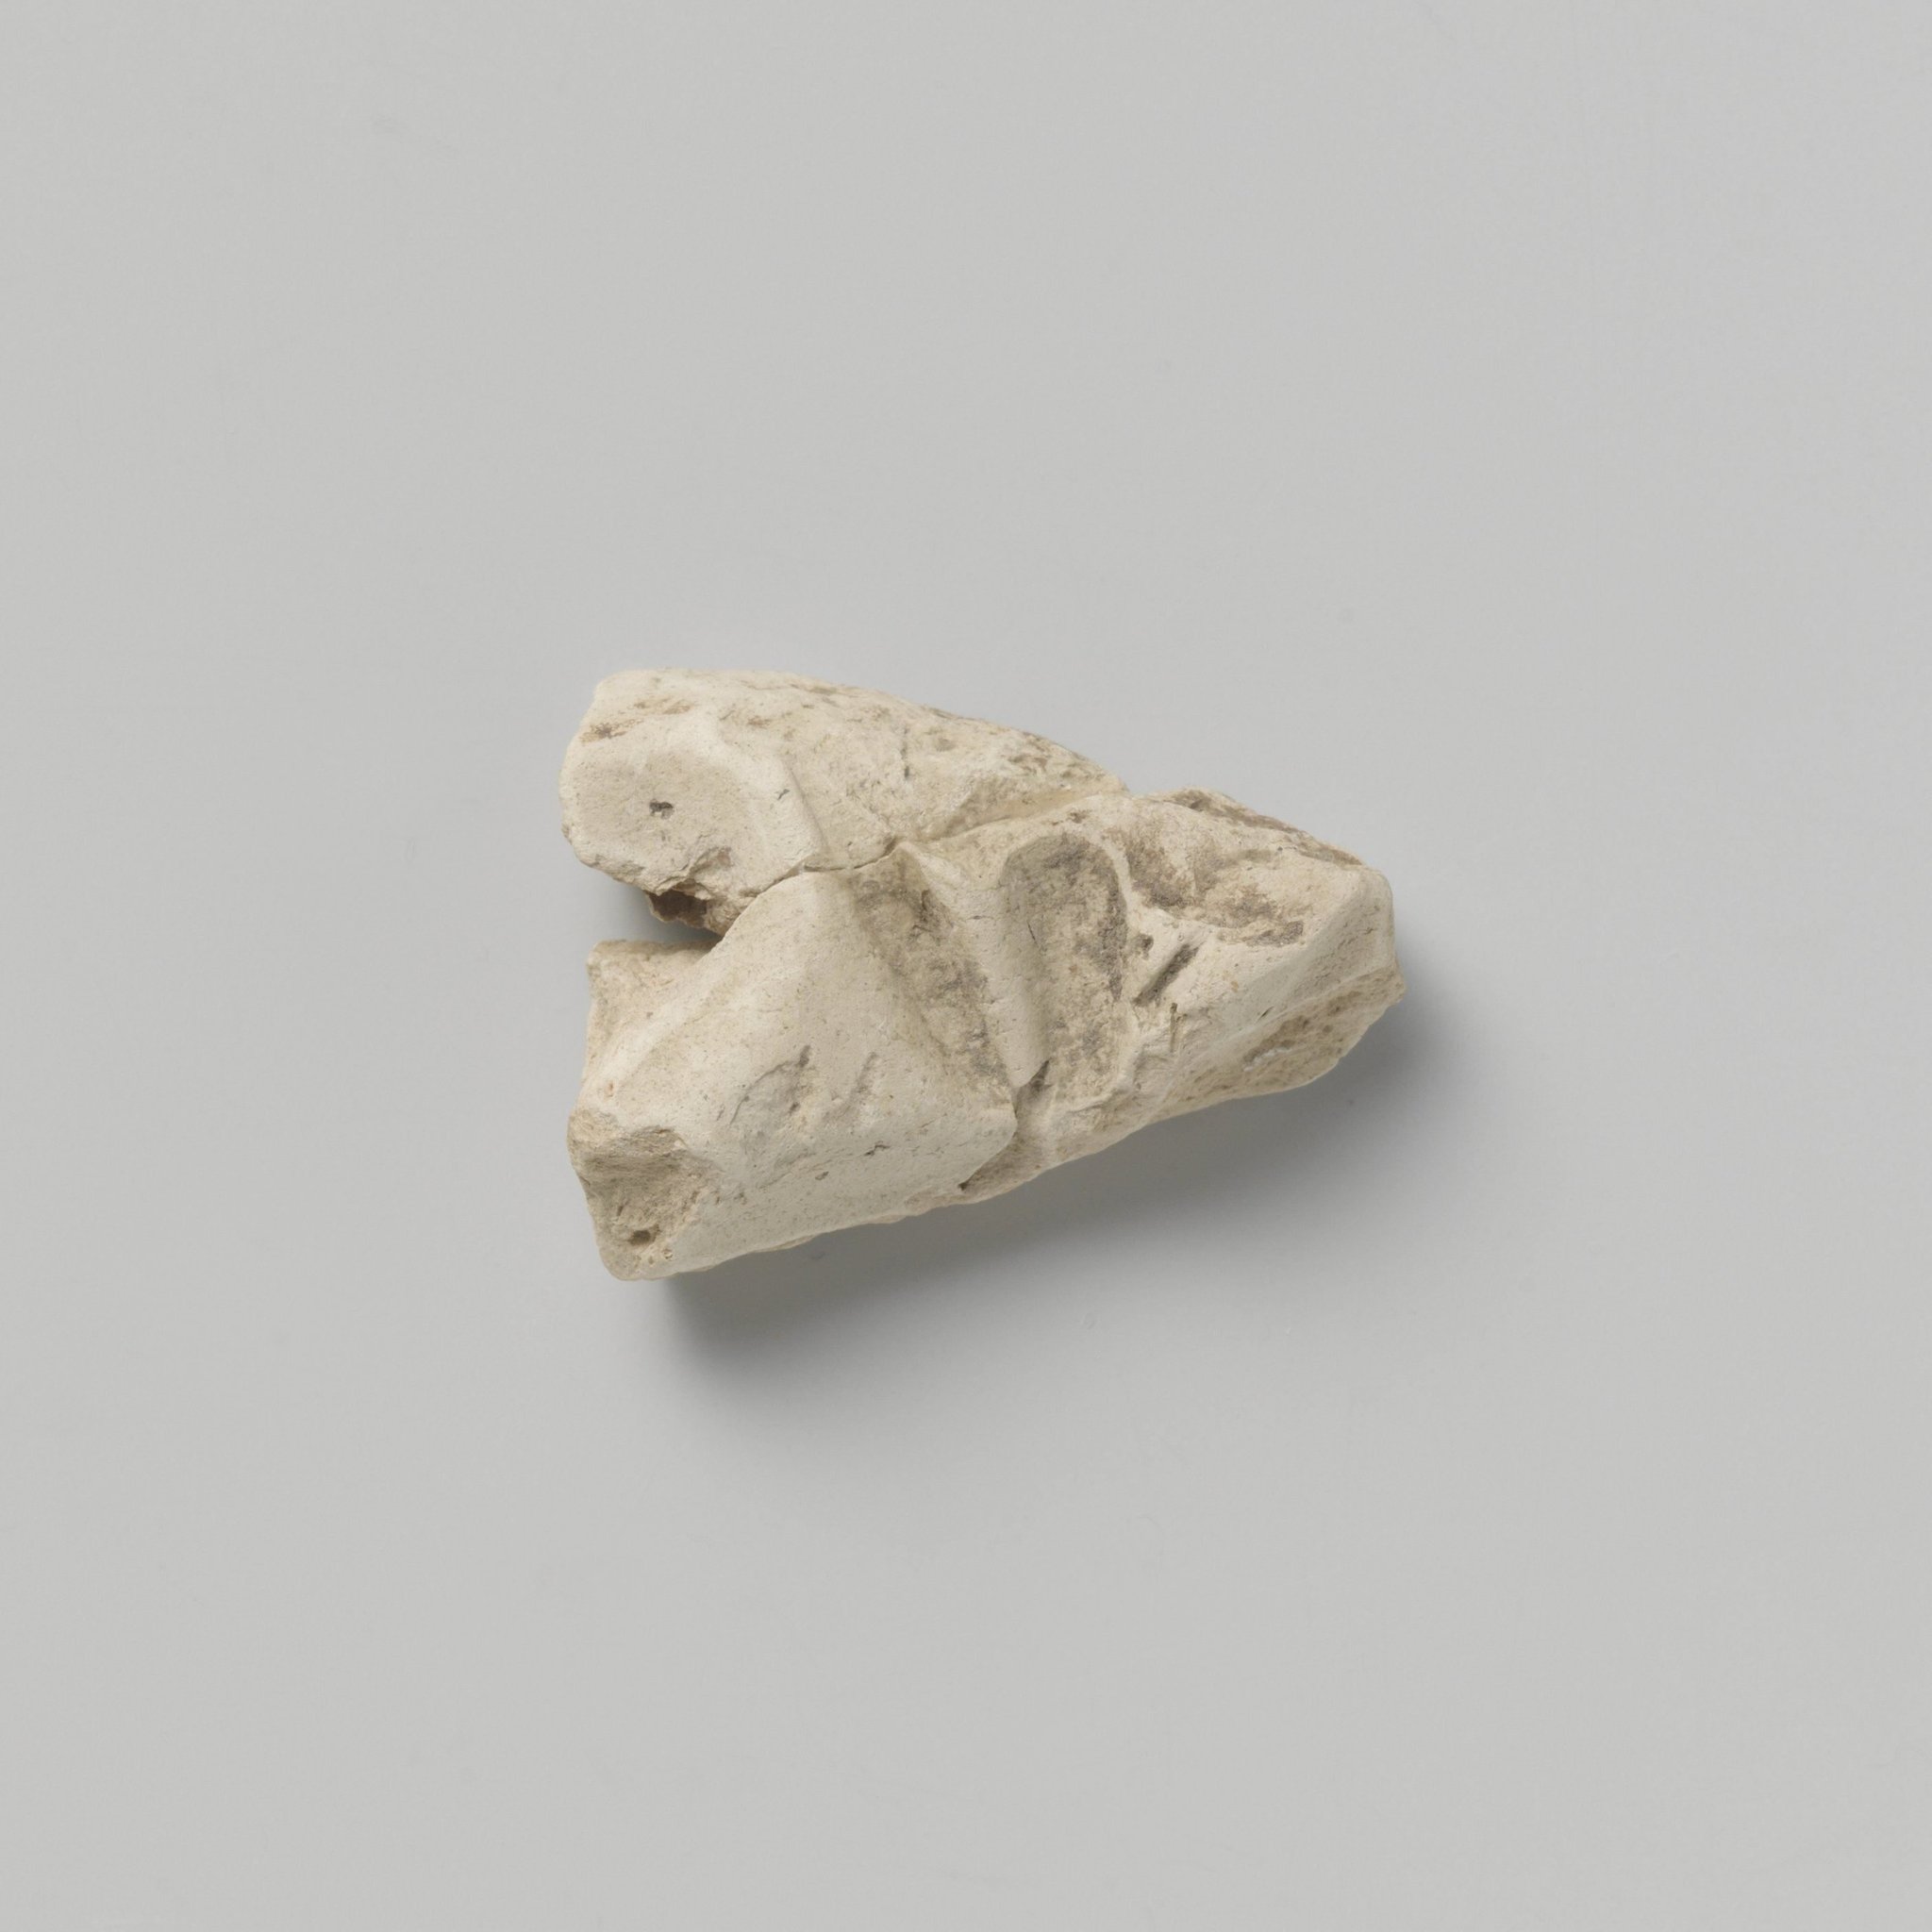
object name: sculpture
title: Fragment of a Figurine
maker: Anonymous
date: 1425-1550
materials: clay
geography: northern netherlands